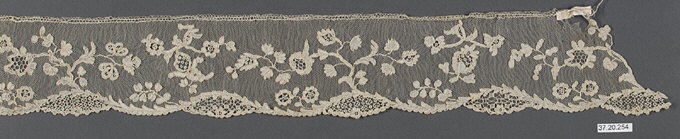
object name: border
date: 1701-1800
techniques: lace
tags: flowers